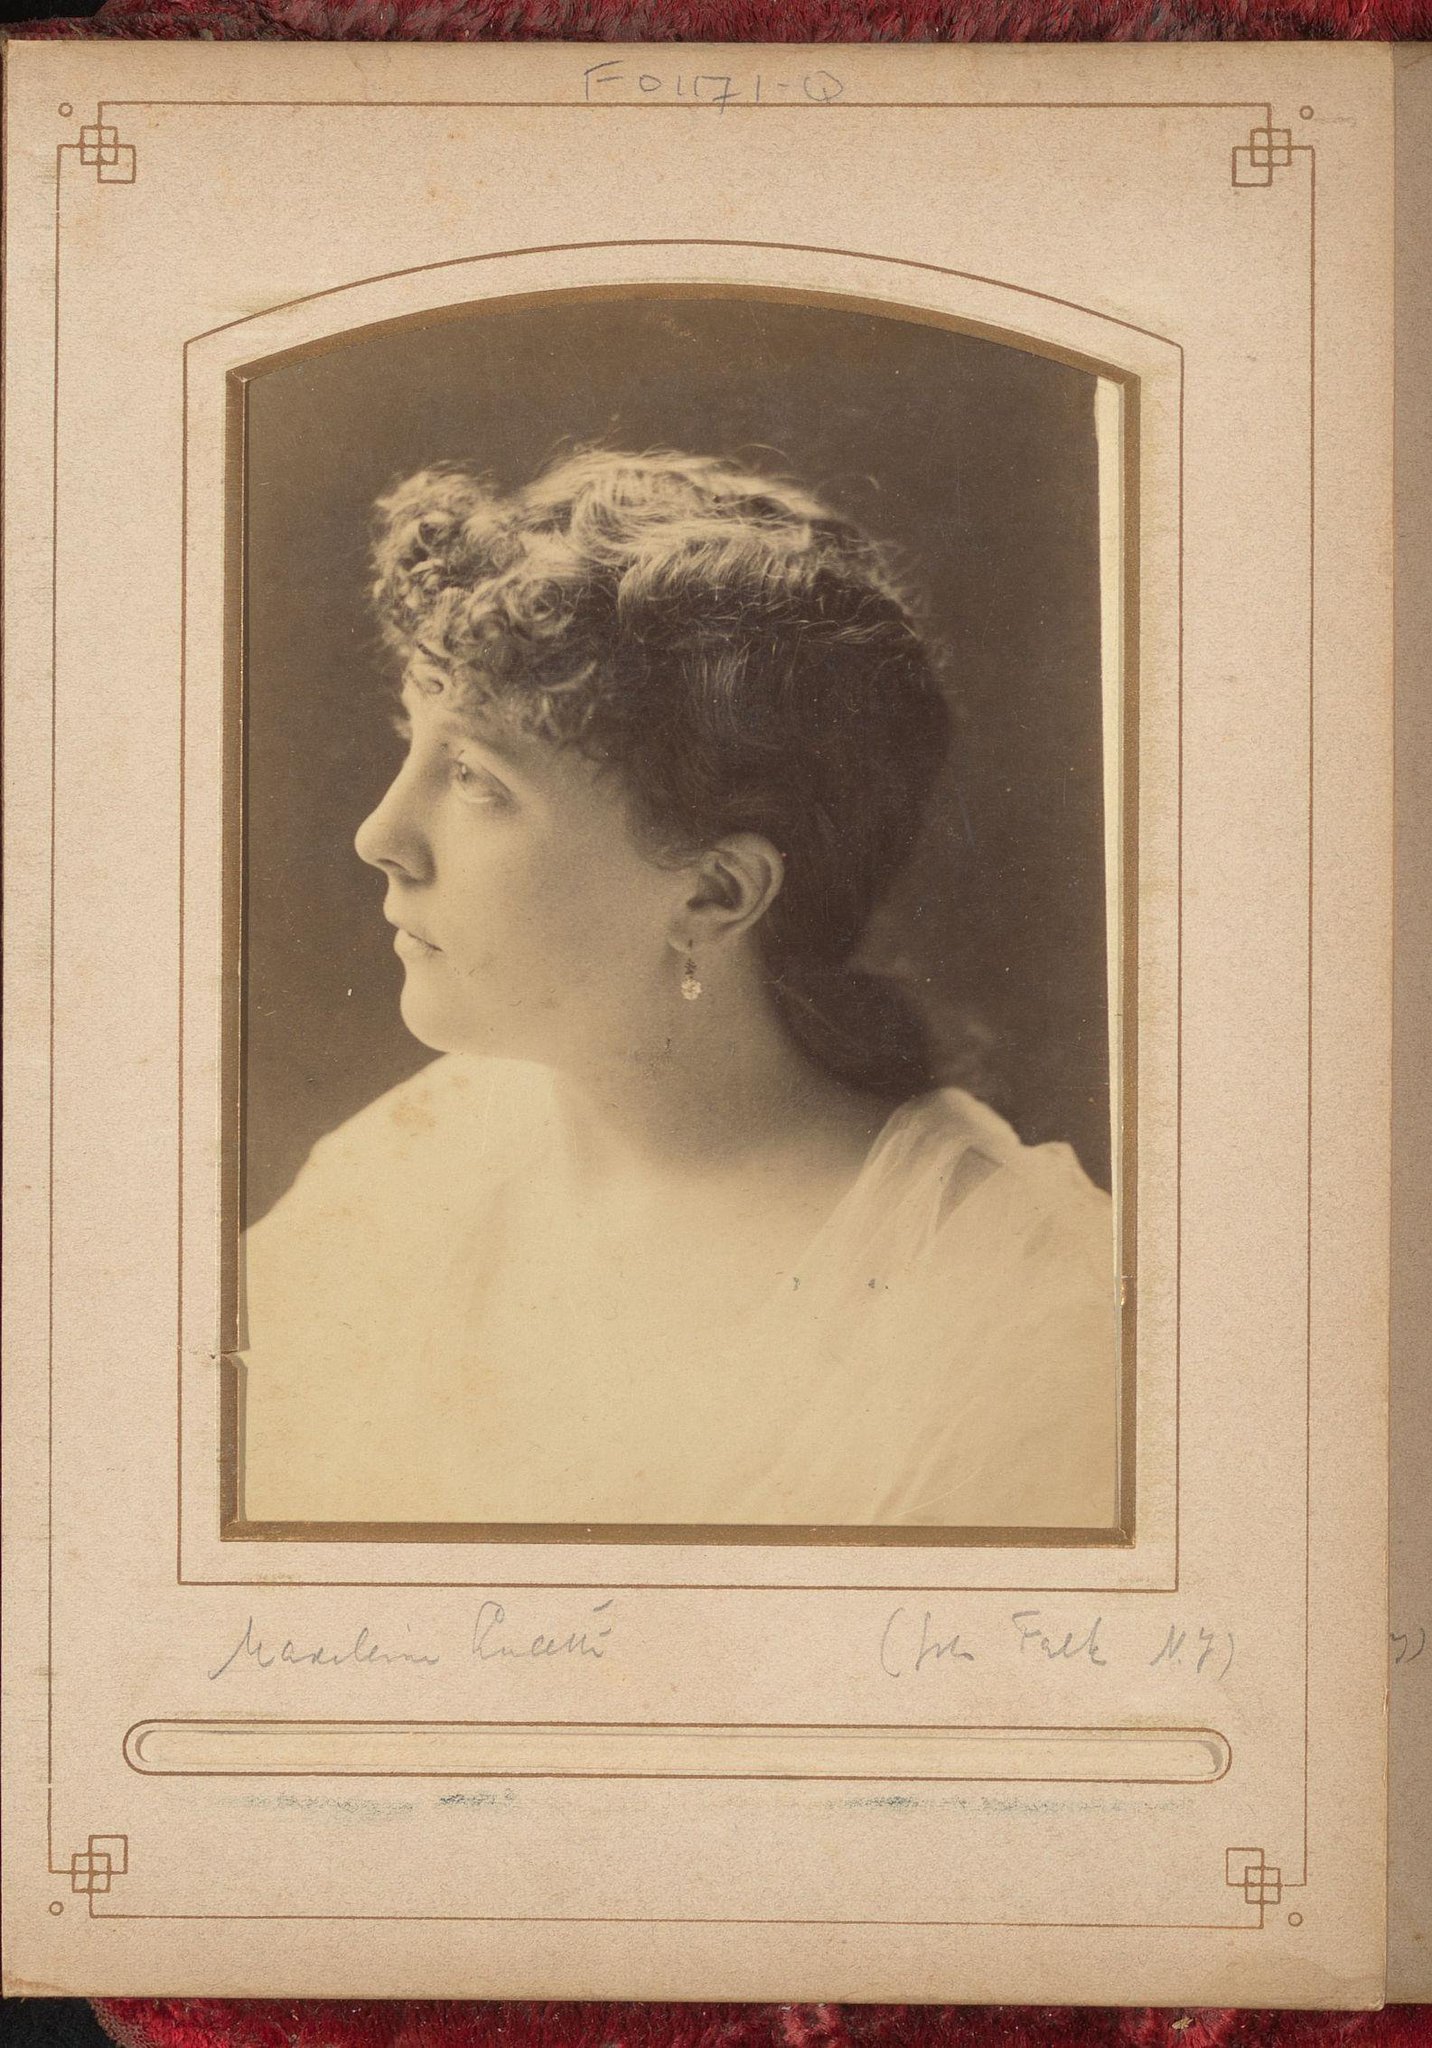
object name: photograph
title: Portret van Madeleine Lucette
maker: benjamin joseph falk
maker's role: fotograaf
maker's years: 1853-1925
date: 1870-1910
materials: cardboard, photographic support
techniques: albumen print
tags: adult woman, portrait of actor, actress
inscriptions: annotation: ‘2193/ 5004/ Madeleine Lucette’, name: ‘Falk 949 Broadway, N.Y.’